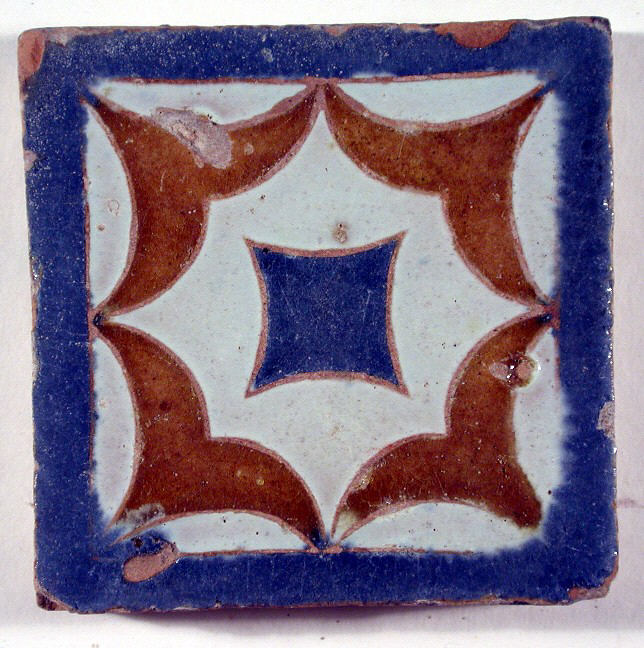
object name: pavement tile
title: Pavement tiles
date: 1501-1700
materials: earthenware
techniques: glazing